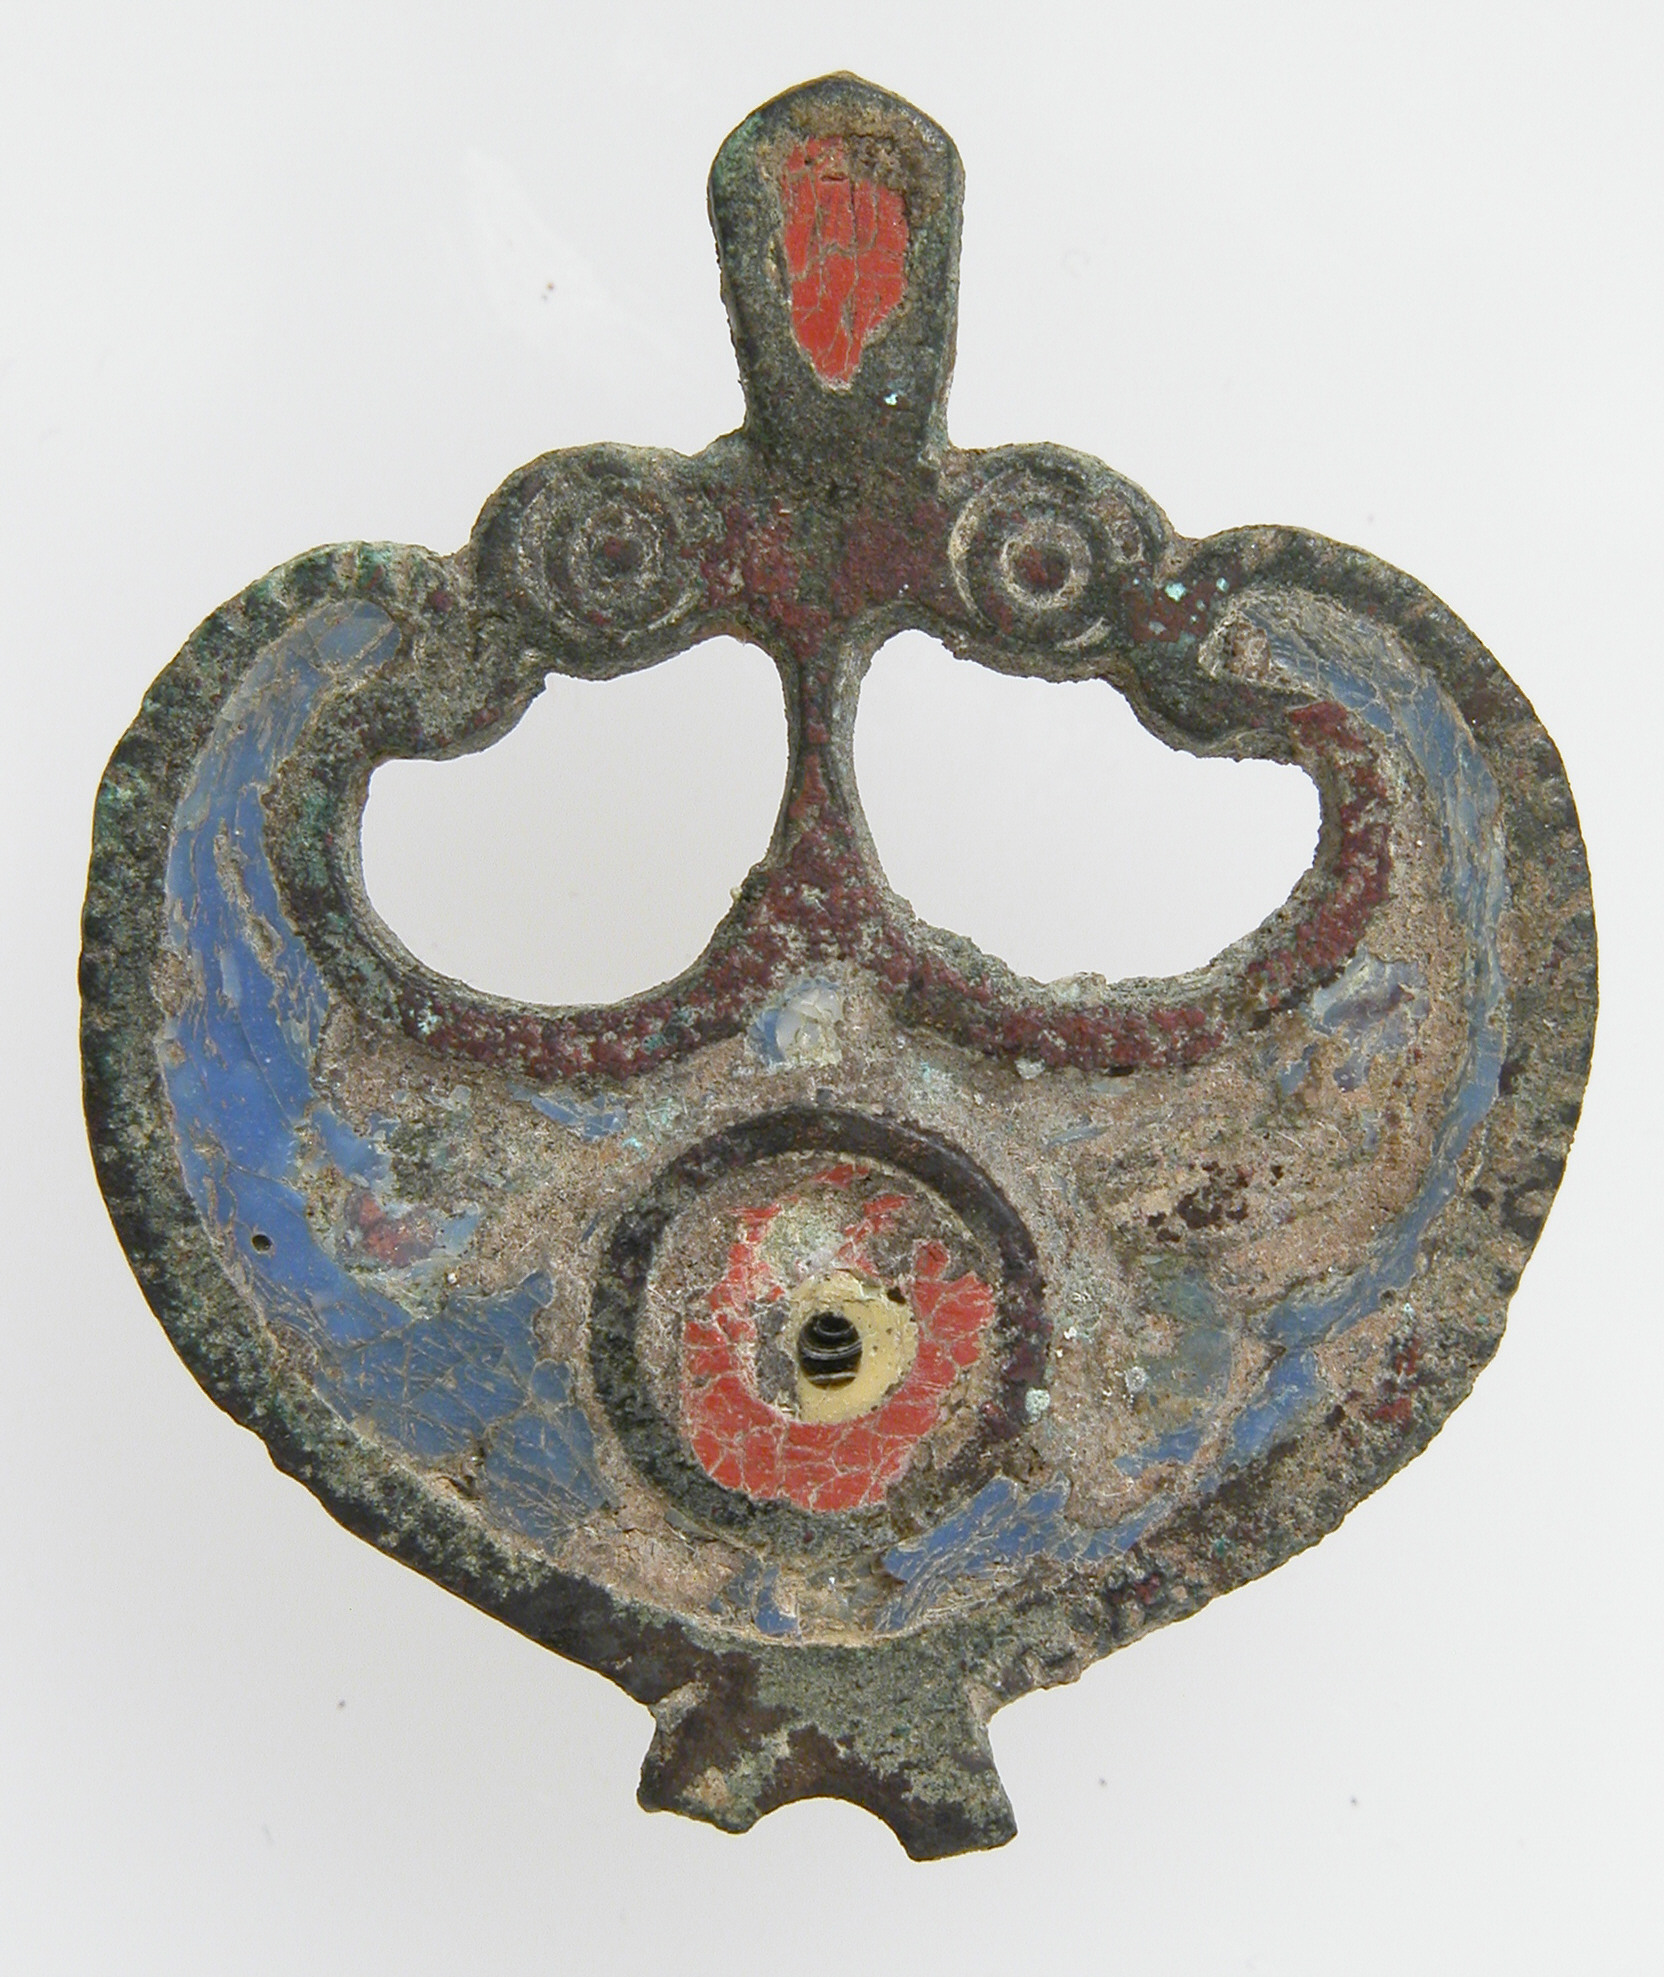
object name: ornament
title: Openwork and Pelta-Shaped Ornament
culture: roman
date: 101-300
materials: bronze, enamel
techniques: enamel